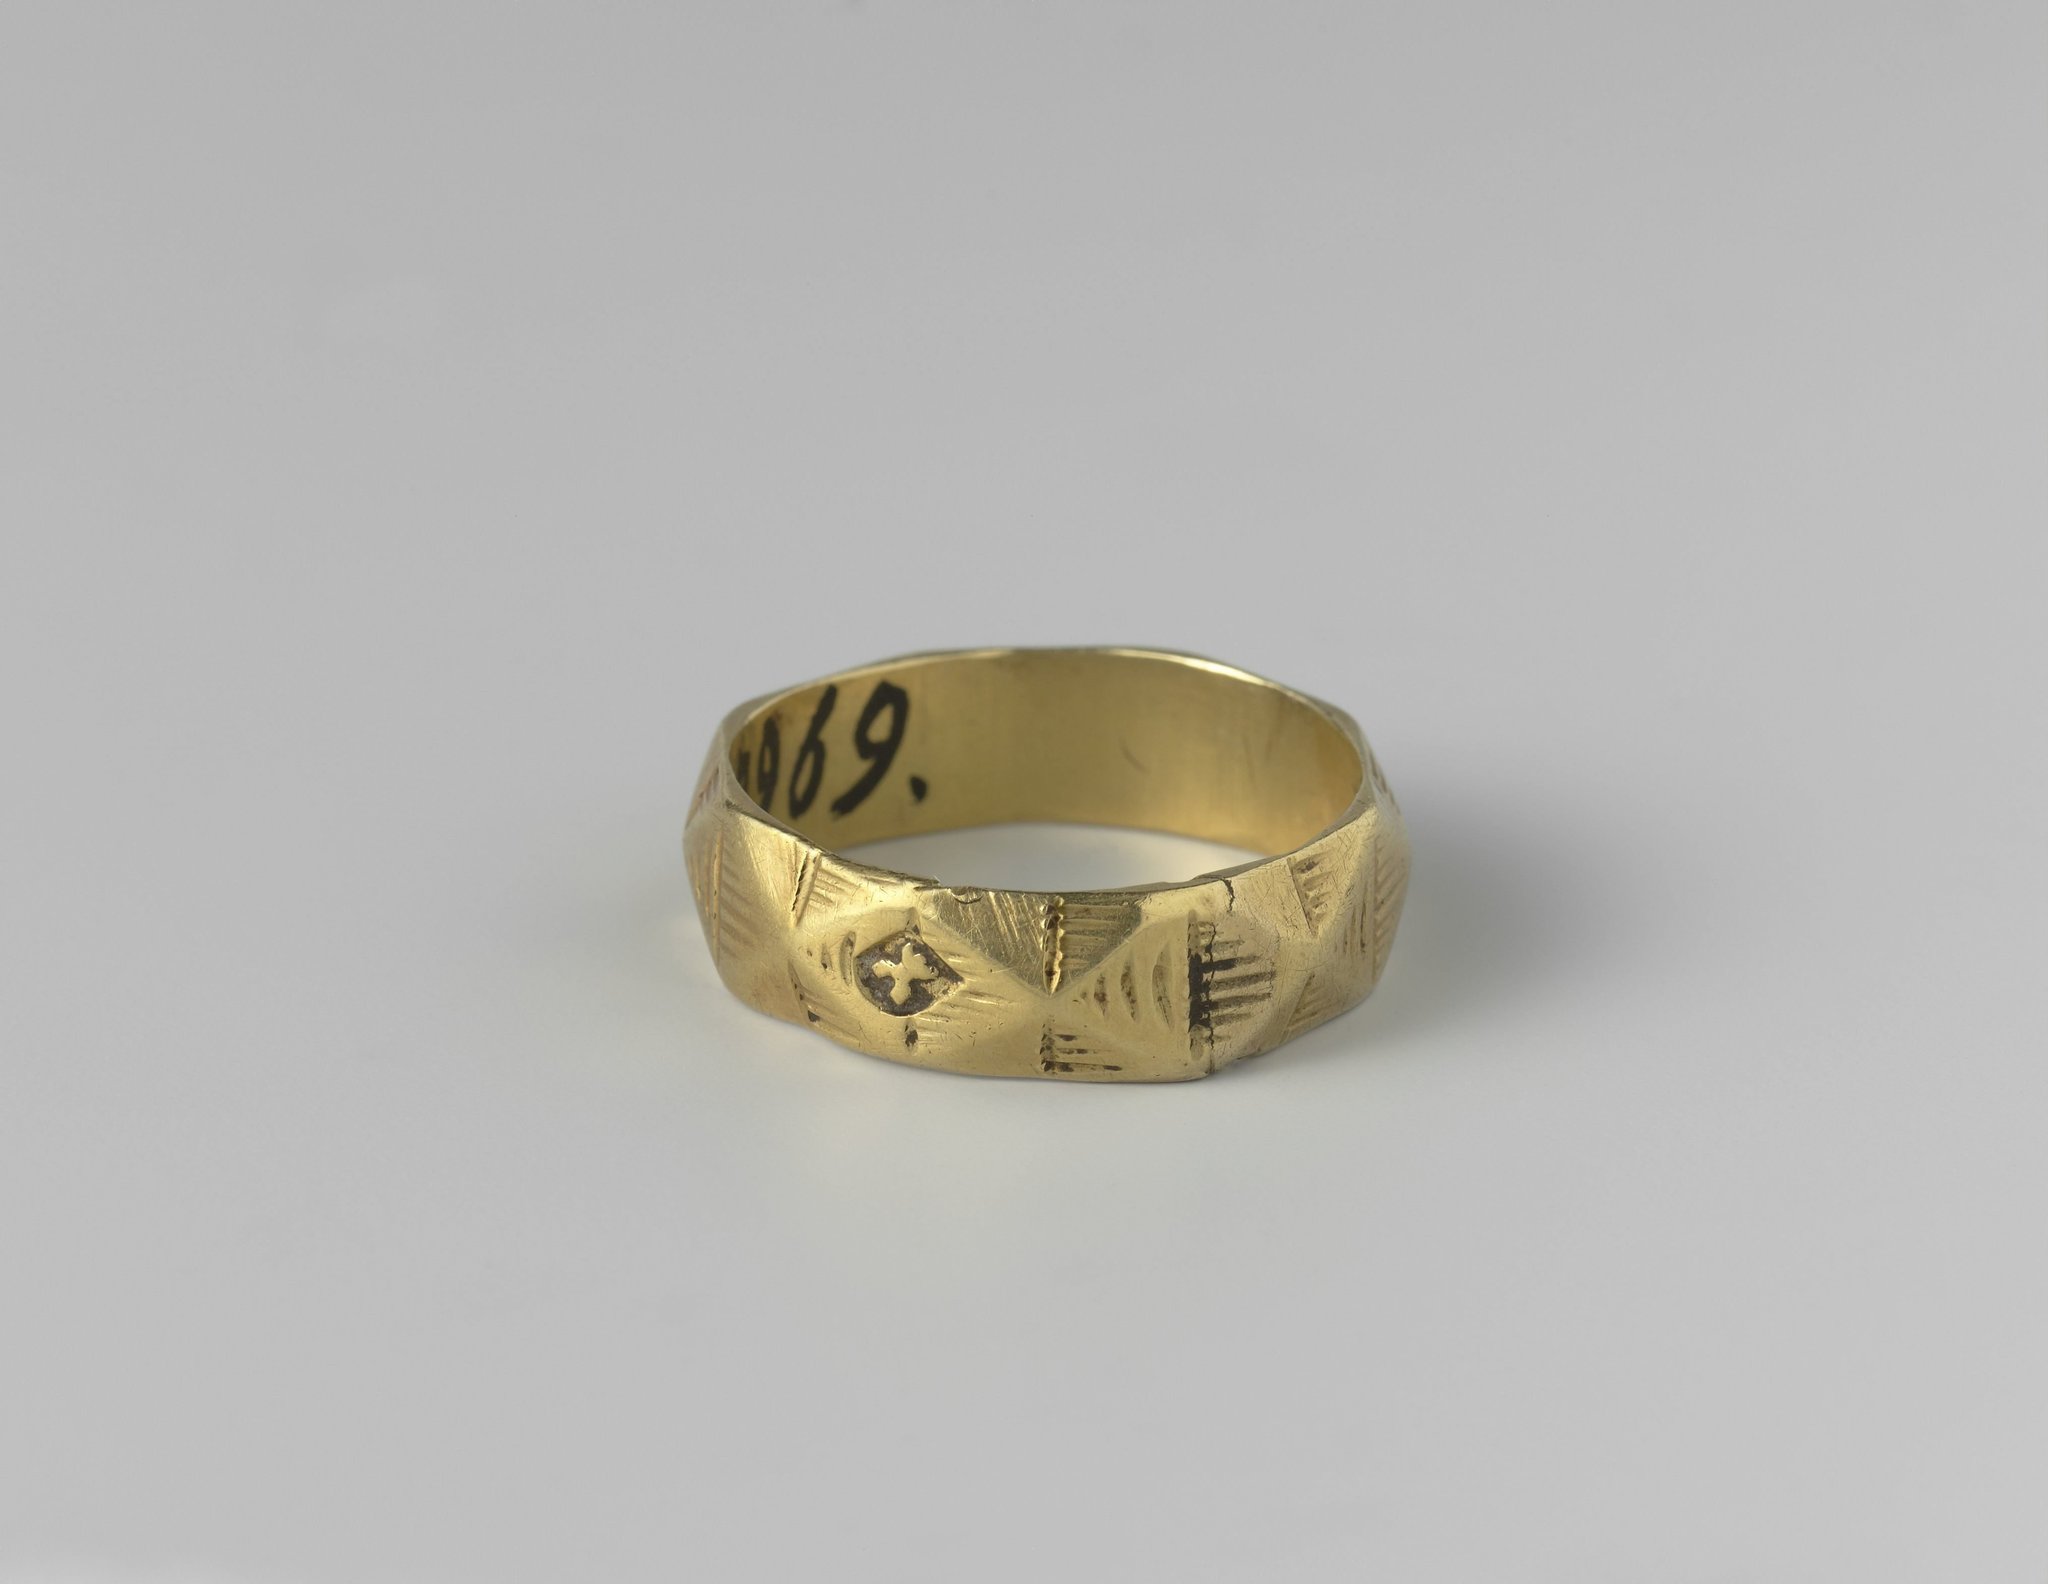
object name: jewellery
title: Ring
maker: Anonymous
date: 1750-1775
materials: gold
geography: middelburg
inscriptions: mark